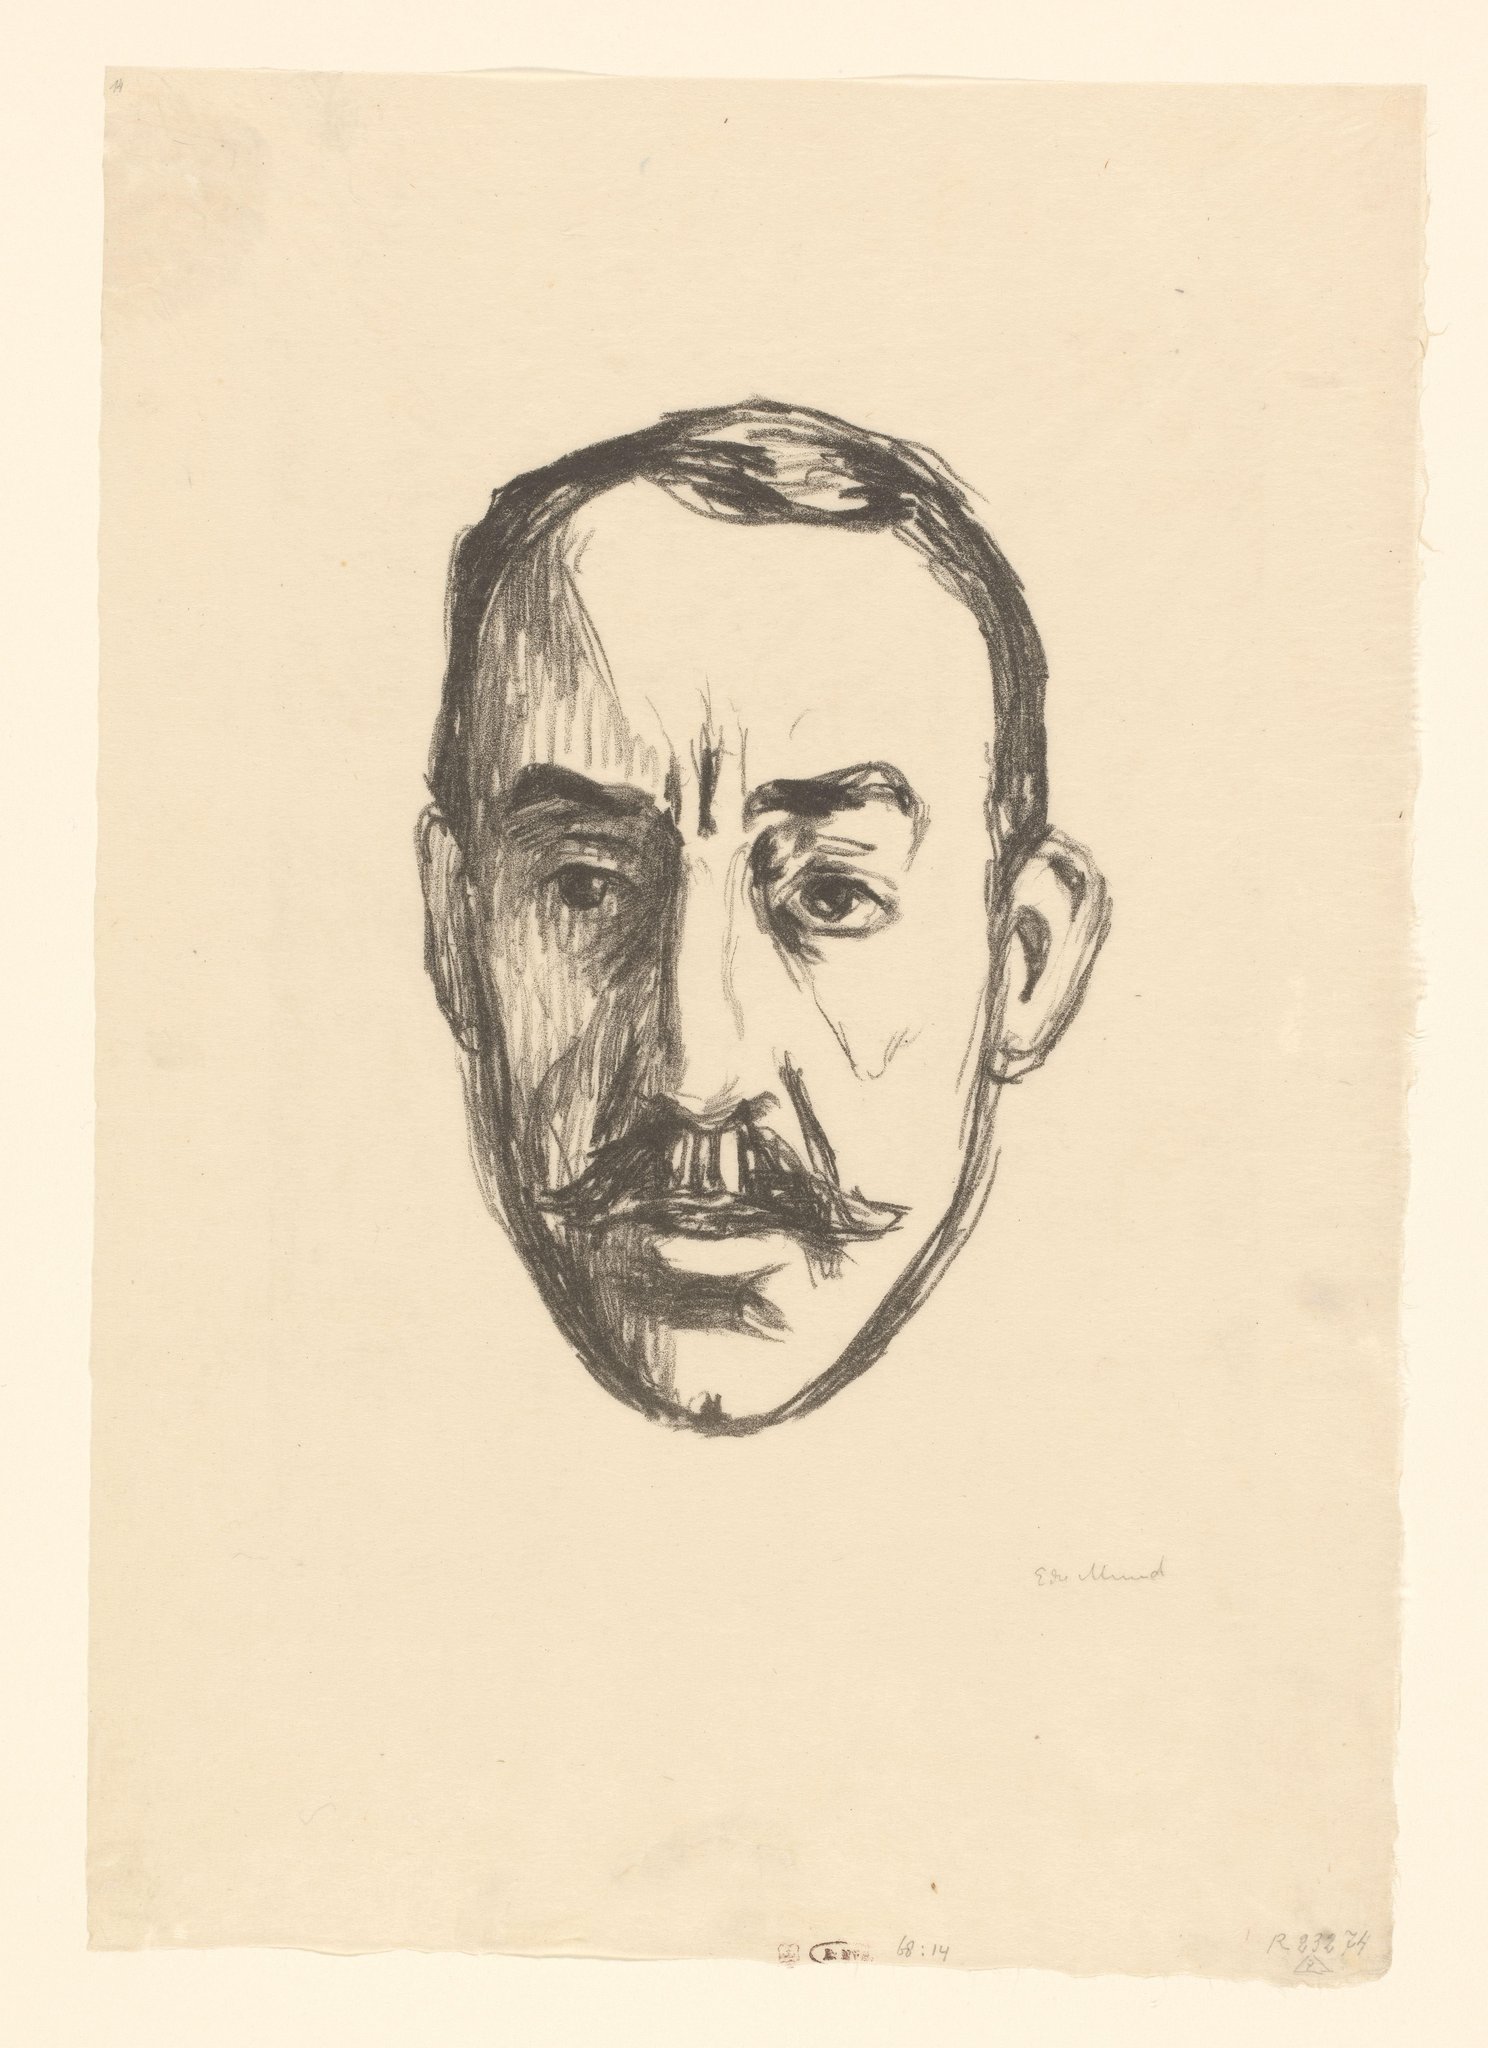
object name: print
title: Portret van Henry van de Velde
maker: edvard munch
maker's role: print maker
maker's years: 1863-1944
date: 1906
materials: paper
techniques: lithograph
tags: antwerp, painter, print maker, draughtsman, henry van de velde (1863-1957), historical persons, portrait, self-portrait of architect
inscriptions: collector's mark: Lugt 2760, collector's mark: Lugt 2228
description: Kop van de Belgische architect en decoratief kunstenaar Henry van de Velde (1863-1957), van voren gezien. Munch ontmoette Van de Velde in Weimar, waar deze een kunstacademie leidde.